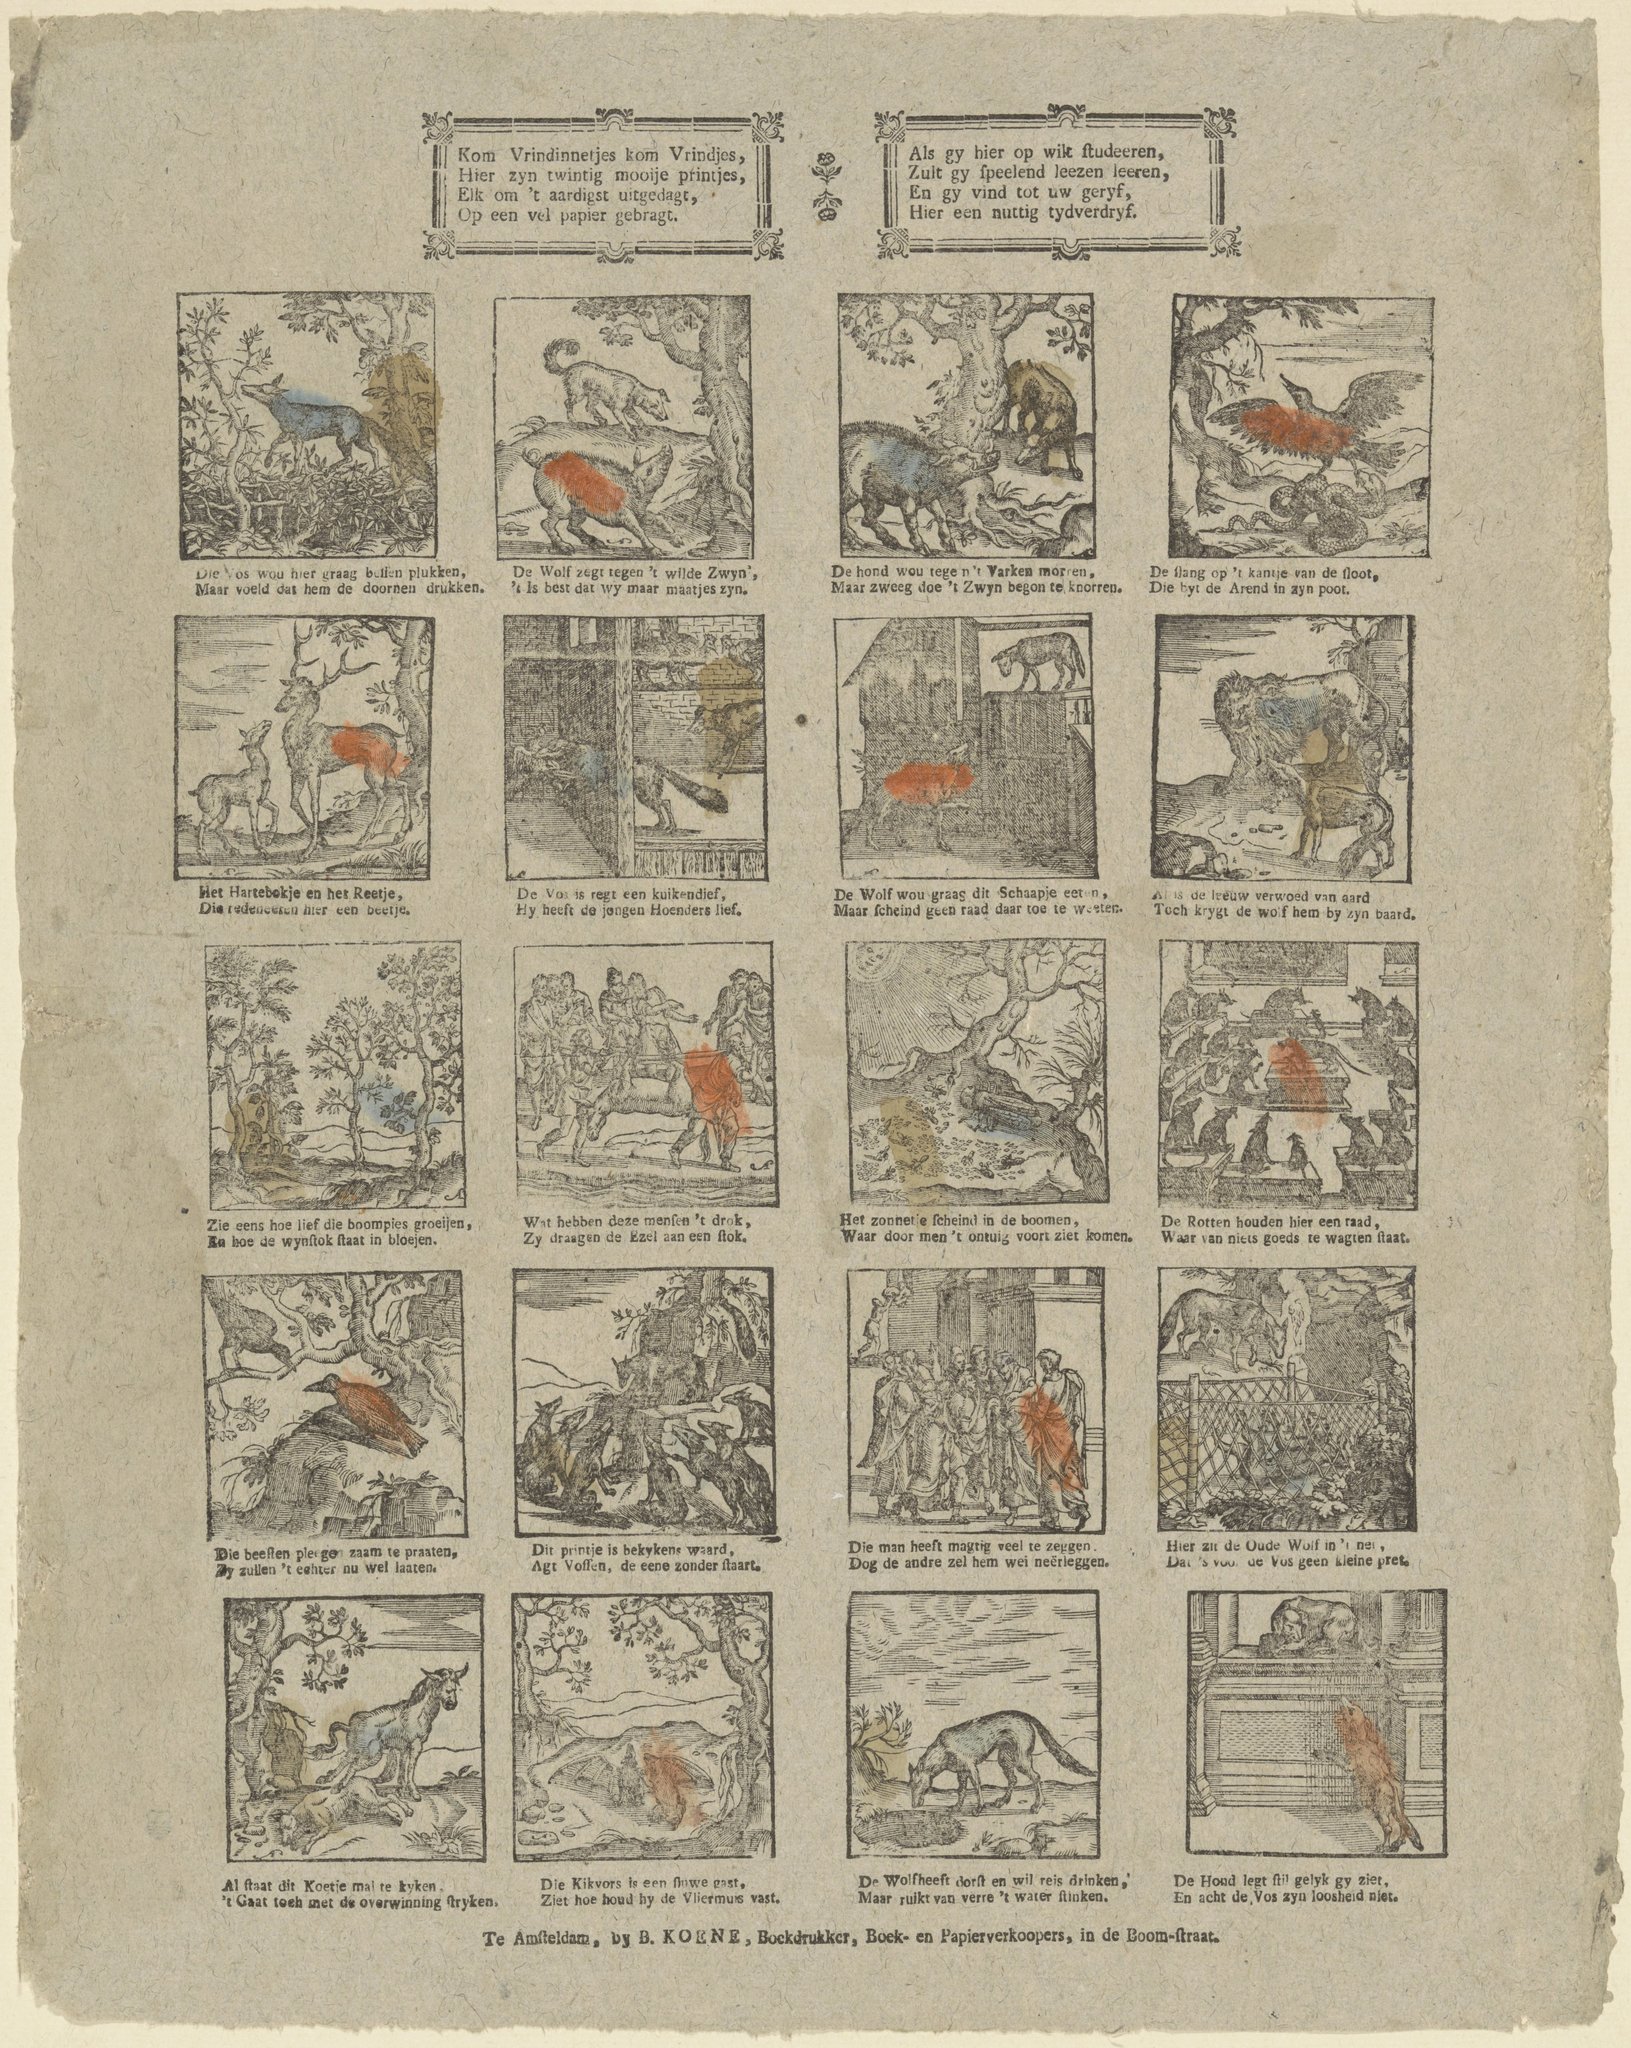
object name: popular print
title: Kom vrindinnetjes kom vrindjes, / Hier zyn twintig mooije printjes (...)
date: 1814-1830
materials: paper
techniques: colour, letterpress printing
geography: amsterdam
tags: fables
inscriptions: collector's mark: Lugt 2760, collector's mark: Lugt 2228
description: Blad met 20 voorstellingen uit de Honderd Fabels (Centum fabulae ex antiquis autoribus delectae, et carminibus explicatae) van Gabriele Faerno. Onder elke afbeelding een tweeregelig vers.